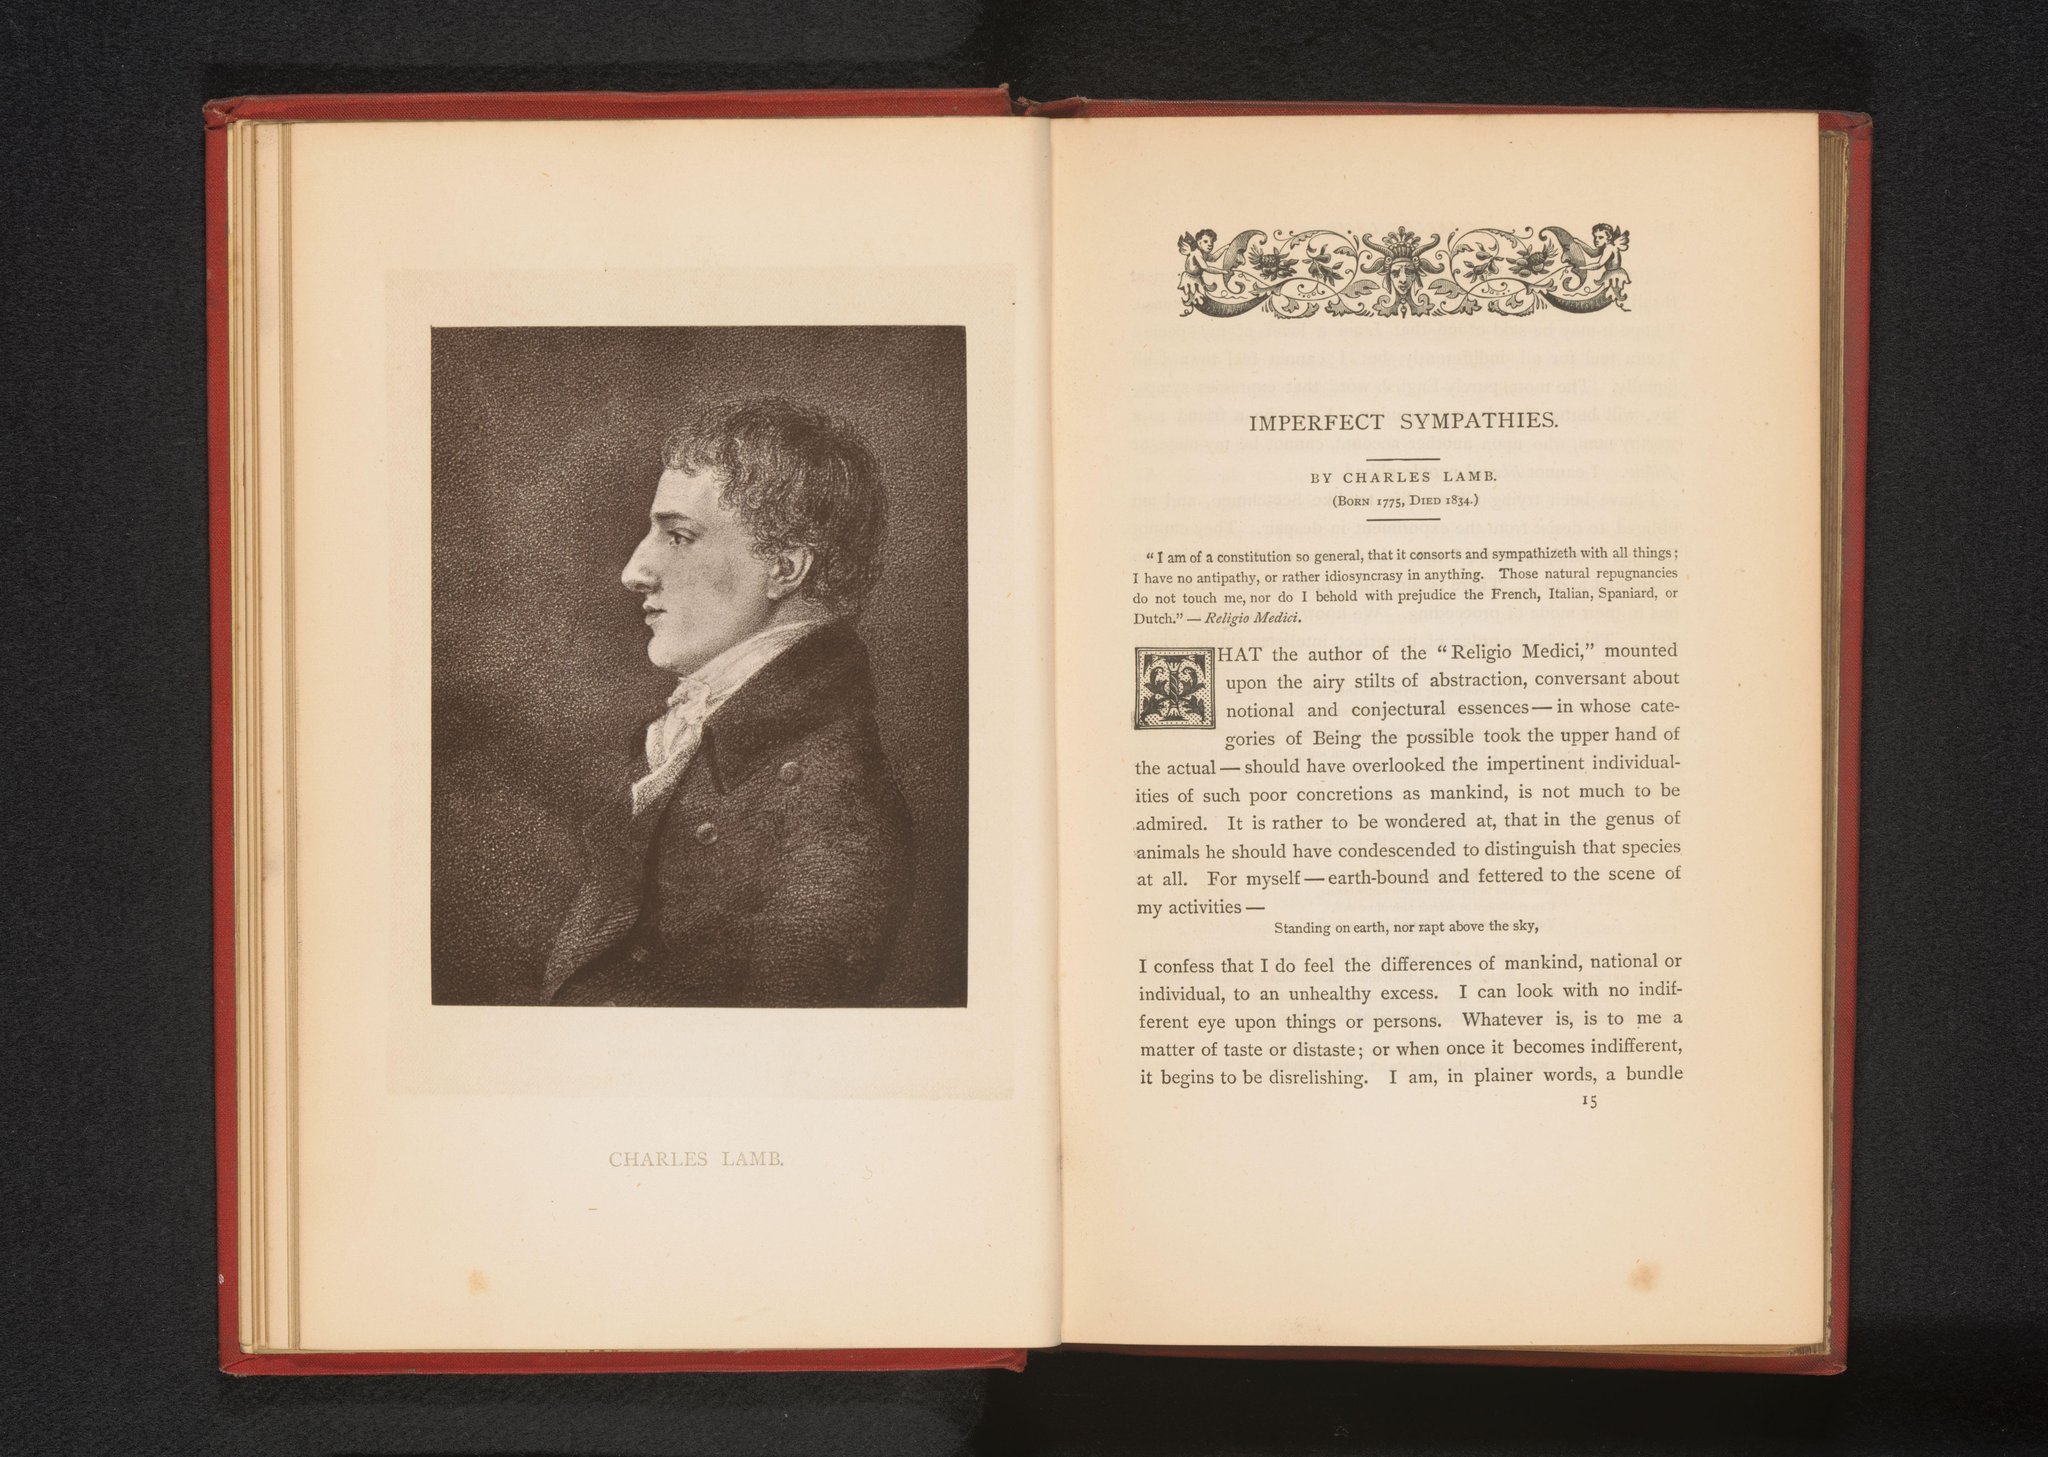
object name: photomechanical print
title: Reproductie van een getekend portret van Charles Lamb door J. Hancock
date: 1881-1886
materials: paper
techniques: woodburytype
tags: charles lamb, adult man, historical persons